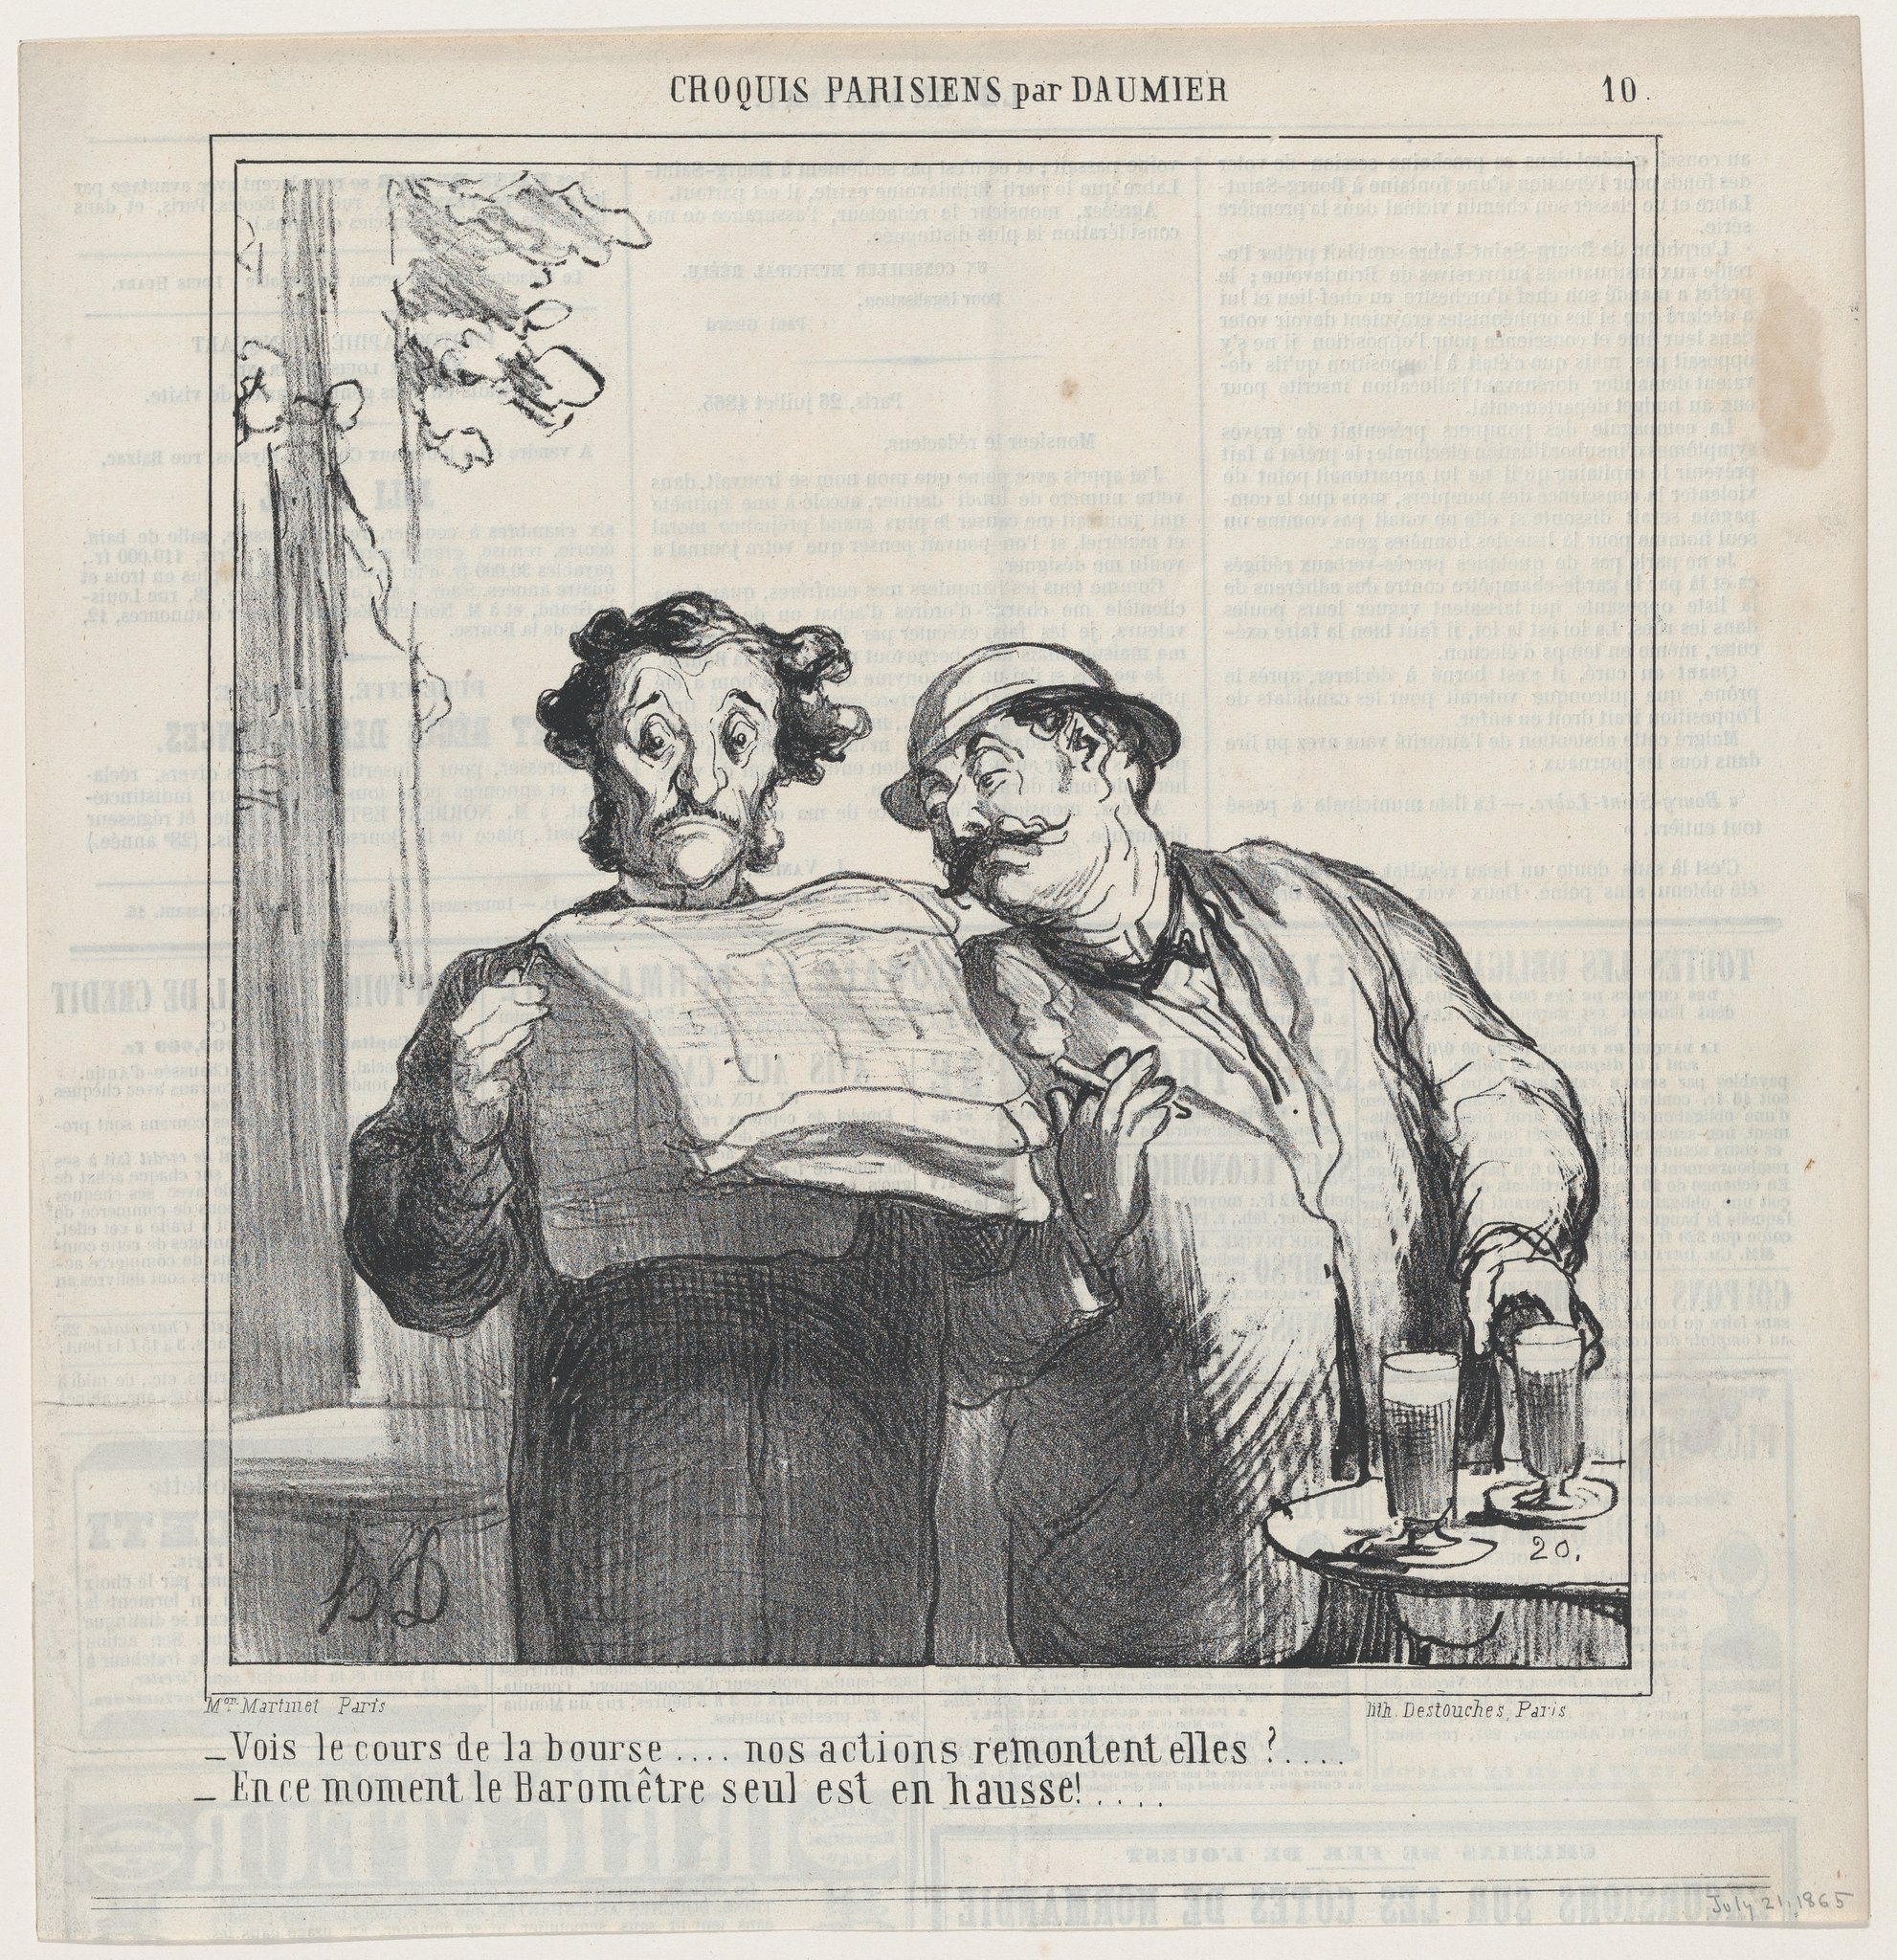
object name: print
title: Look, the quotations from the stock exchange... are our shares going up?, from 'Parisian Sketches,' published in Le Charivari, July 21, 1865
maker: honoré daumier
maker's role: artist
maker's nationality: french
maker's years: 1808-1879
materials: paper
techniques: lithograph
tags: men,reading,smoking